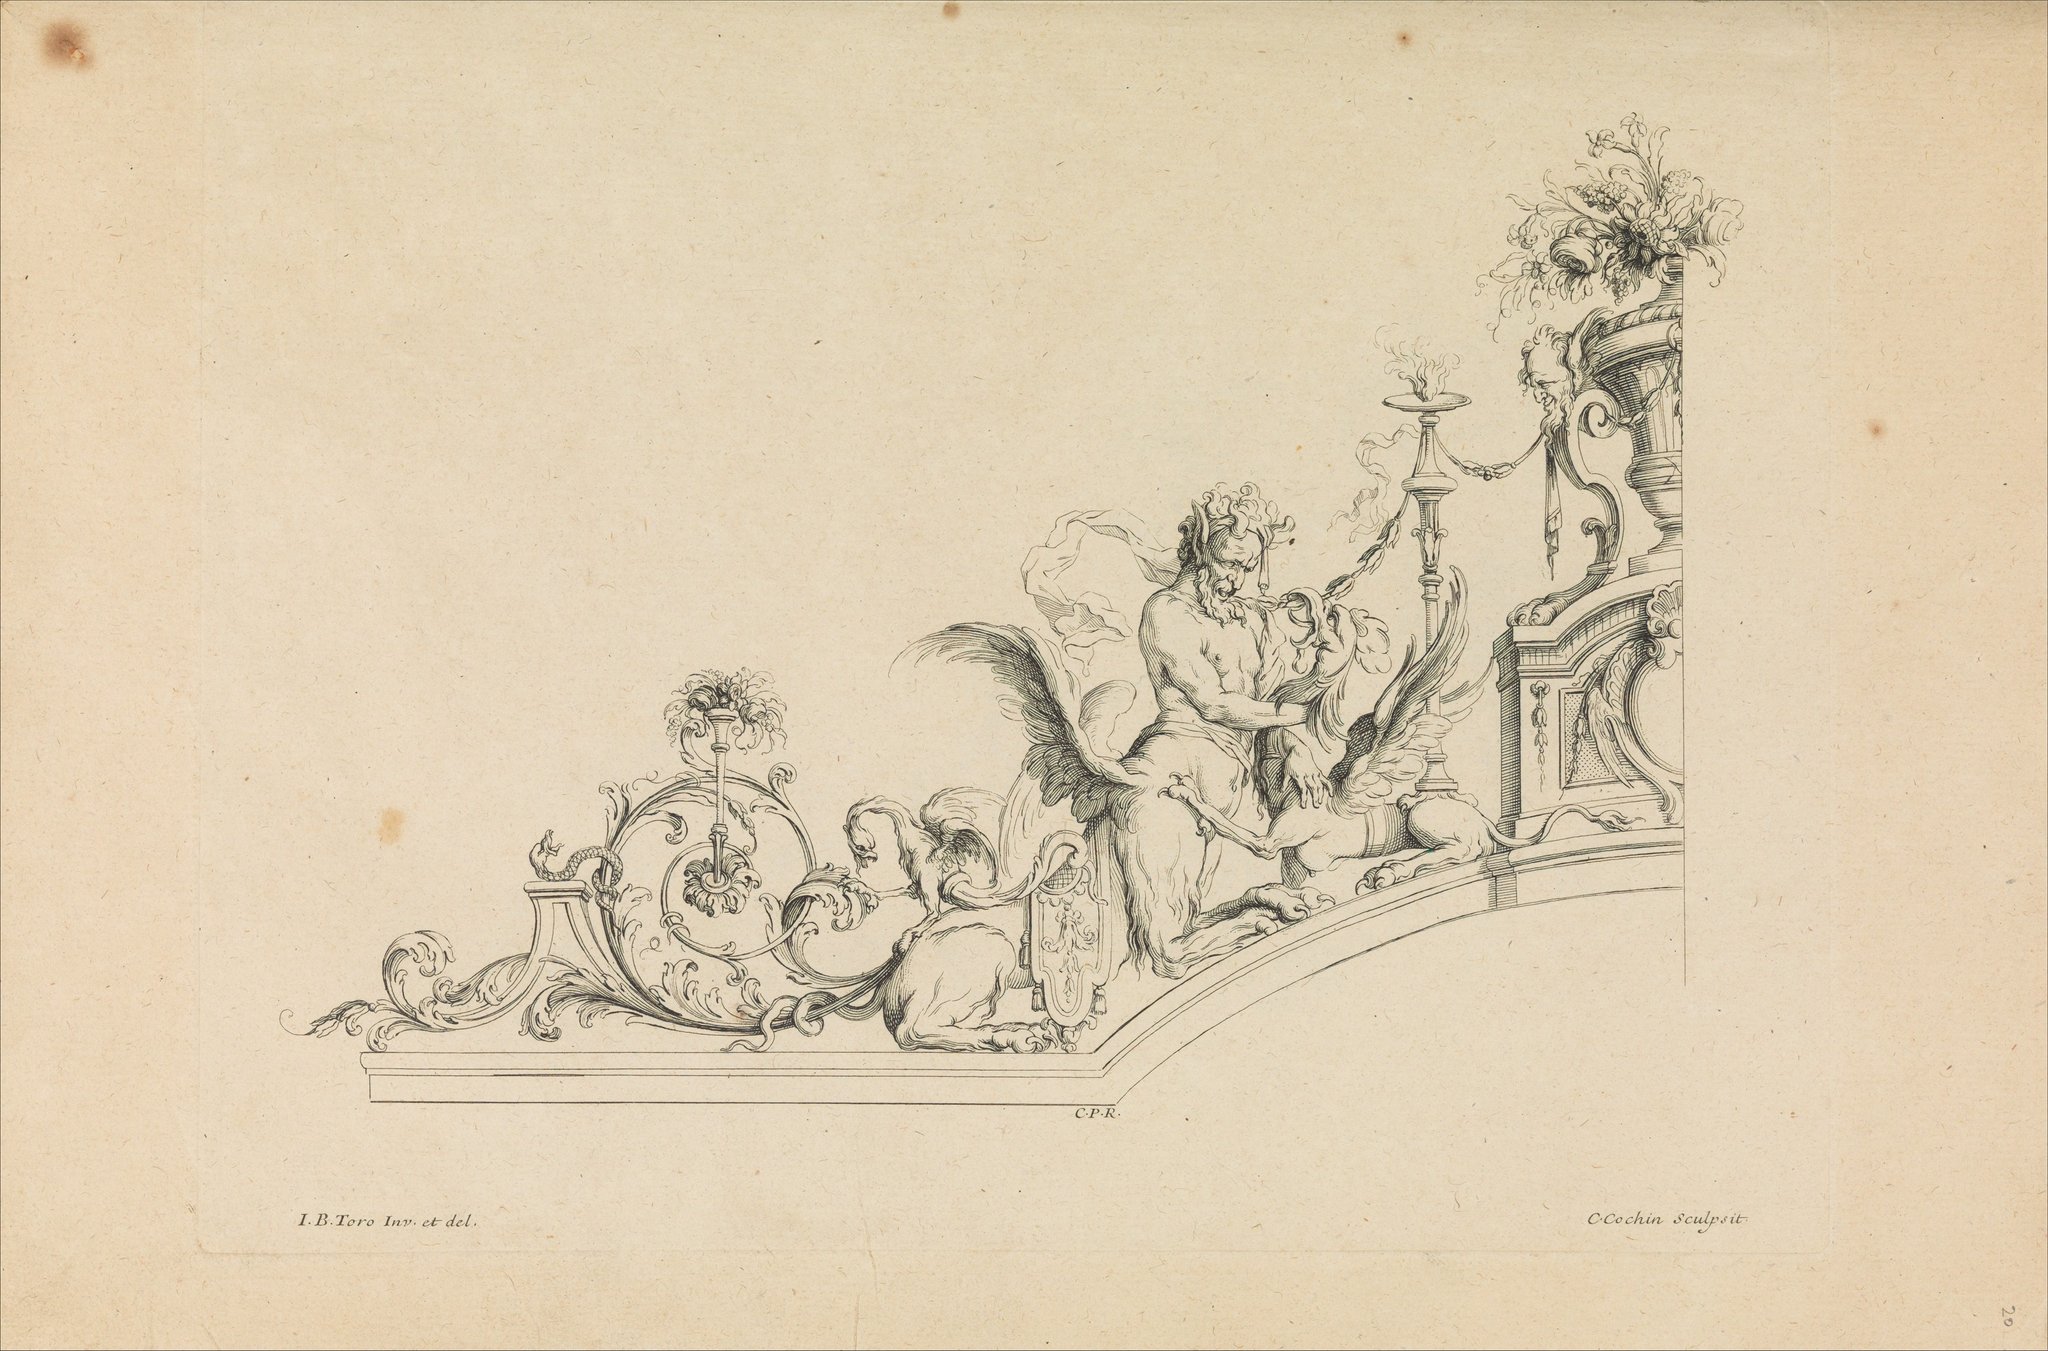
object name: album print ornament architecture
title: Desseins Arabesques a Plusieurs Usages Inventés par J.B. Toro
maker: jean bernard toro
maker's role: designer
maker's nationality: french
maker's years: 1672-1731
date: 1716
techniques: etching